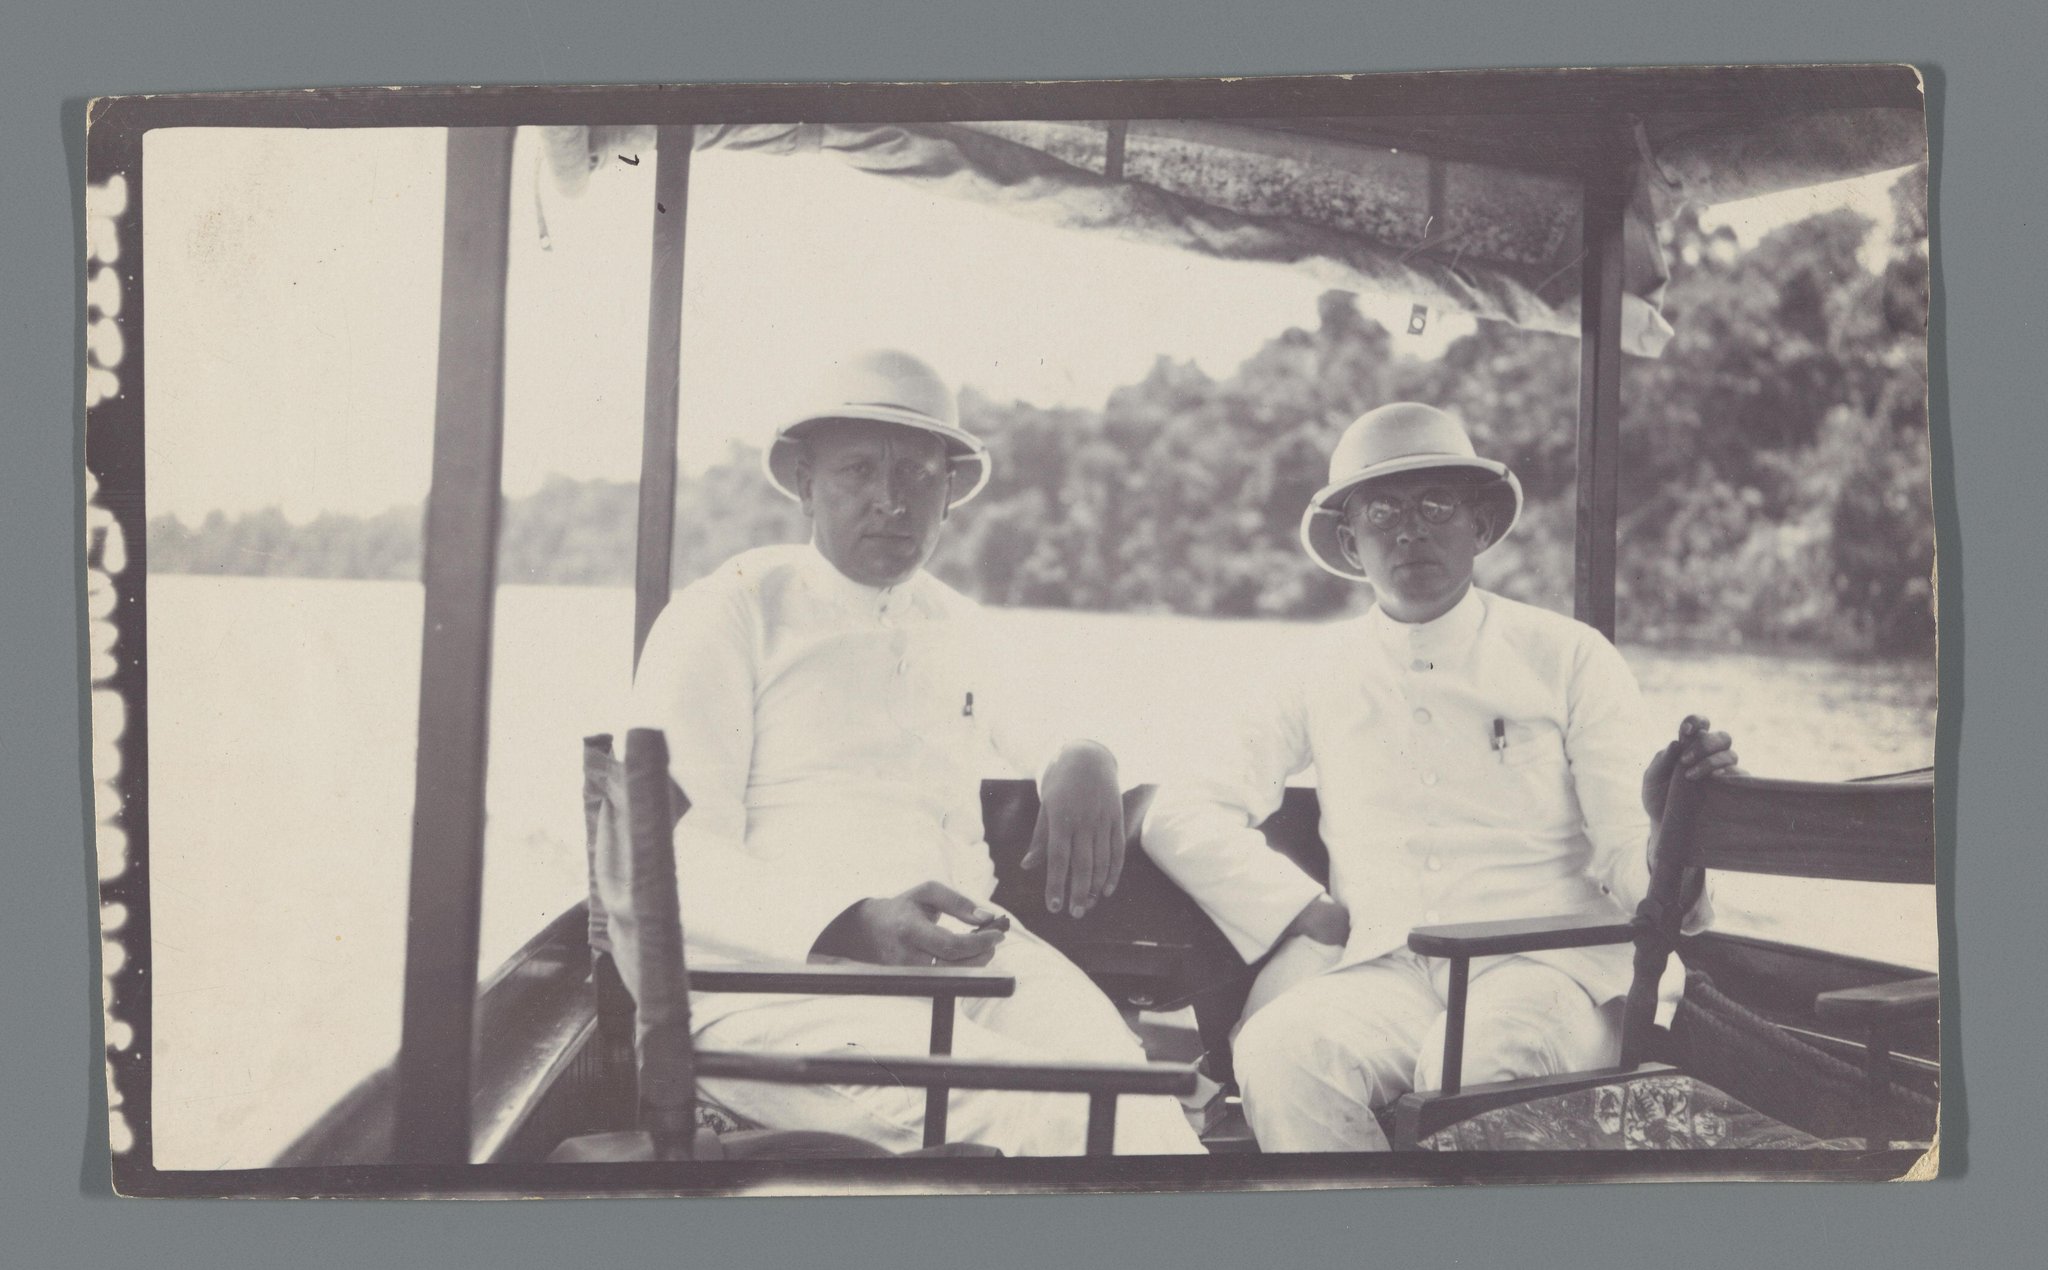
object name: photograph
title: Ingenieur Jetten met Compaan in de Edward Lewis op weg naar Moengo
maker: Anonymous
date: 1925-1927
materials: photographic support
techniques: photography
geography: suriname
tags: jetten, familie, moengo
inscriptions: inscription: ‘Compaan en ik in de Edward Lewis op weg naar Moengo. Ze hebben hier een stuk of 5 snel varende moterboten. ' morgens tegen 8 uur vertrokken: halfvijf in Moengo 160 km in 8½ uur’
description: Ingenieur Jetten met Compaan in de boot Edward Lewis op weg naar Moengo. Onderdeel van het ensemble met foto's van de familie van ingenieur Jetten in de mijnbouwstad Moengo in Suriname.